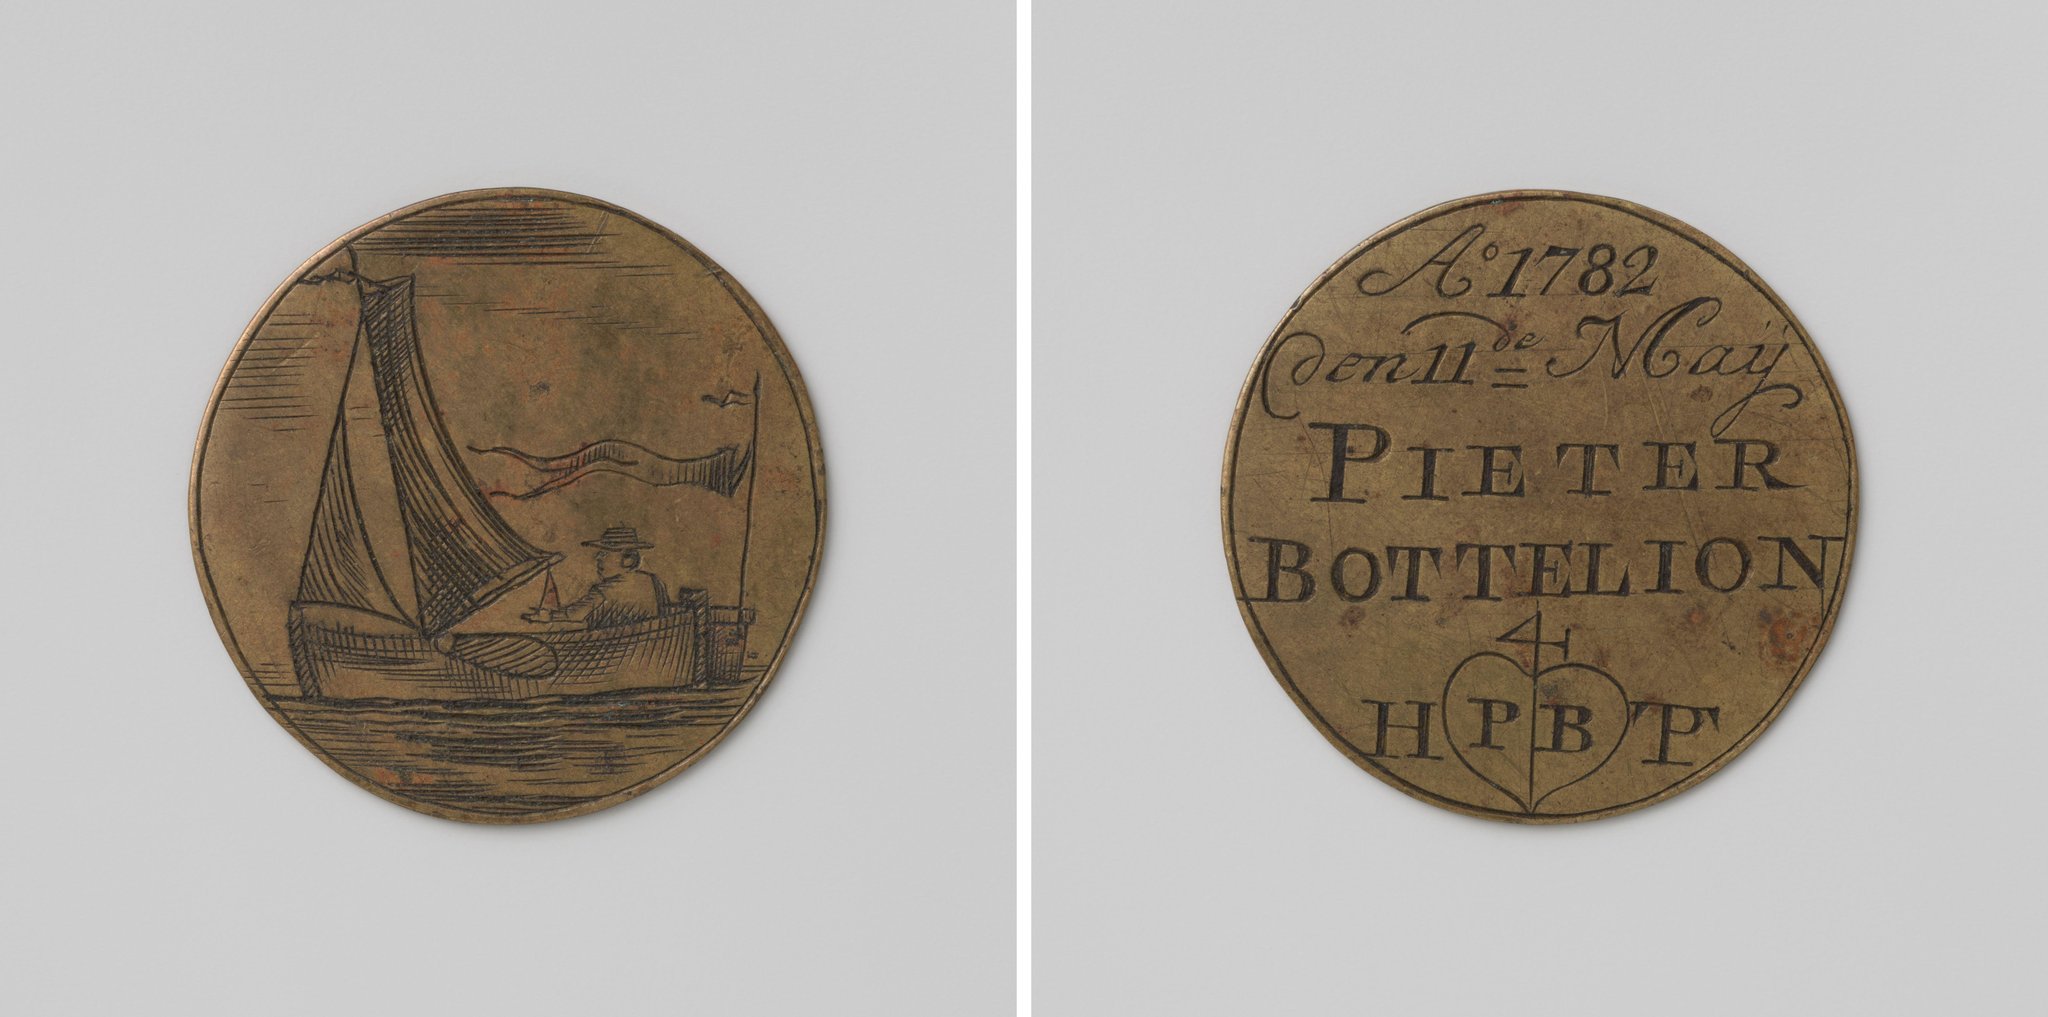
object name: medal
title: Roei-, steiger- en schuitenvoerdersgilde van Amsterdam, gildepenning van Pieter Bottelion, ligplaats Haringpakkerstoren-steiger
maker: Anonymous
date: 1782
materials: brass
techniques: engraving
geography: amsterdam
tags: amsterdam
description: Messing penning. Voorzijde: naar links varende zeilboot; op achterplecht: zittende man en vlag. Keerzijde: opschrift boven huismerk en hart met daarin letters P en B tussen monogram van letters H, P en T